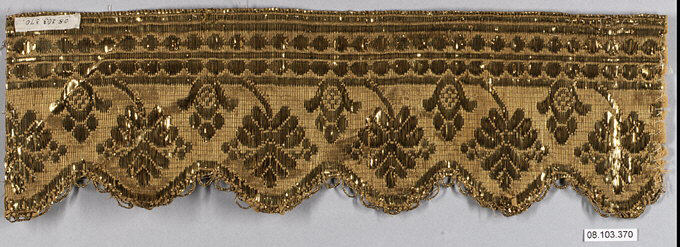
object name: galloon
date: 1601-1800